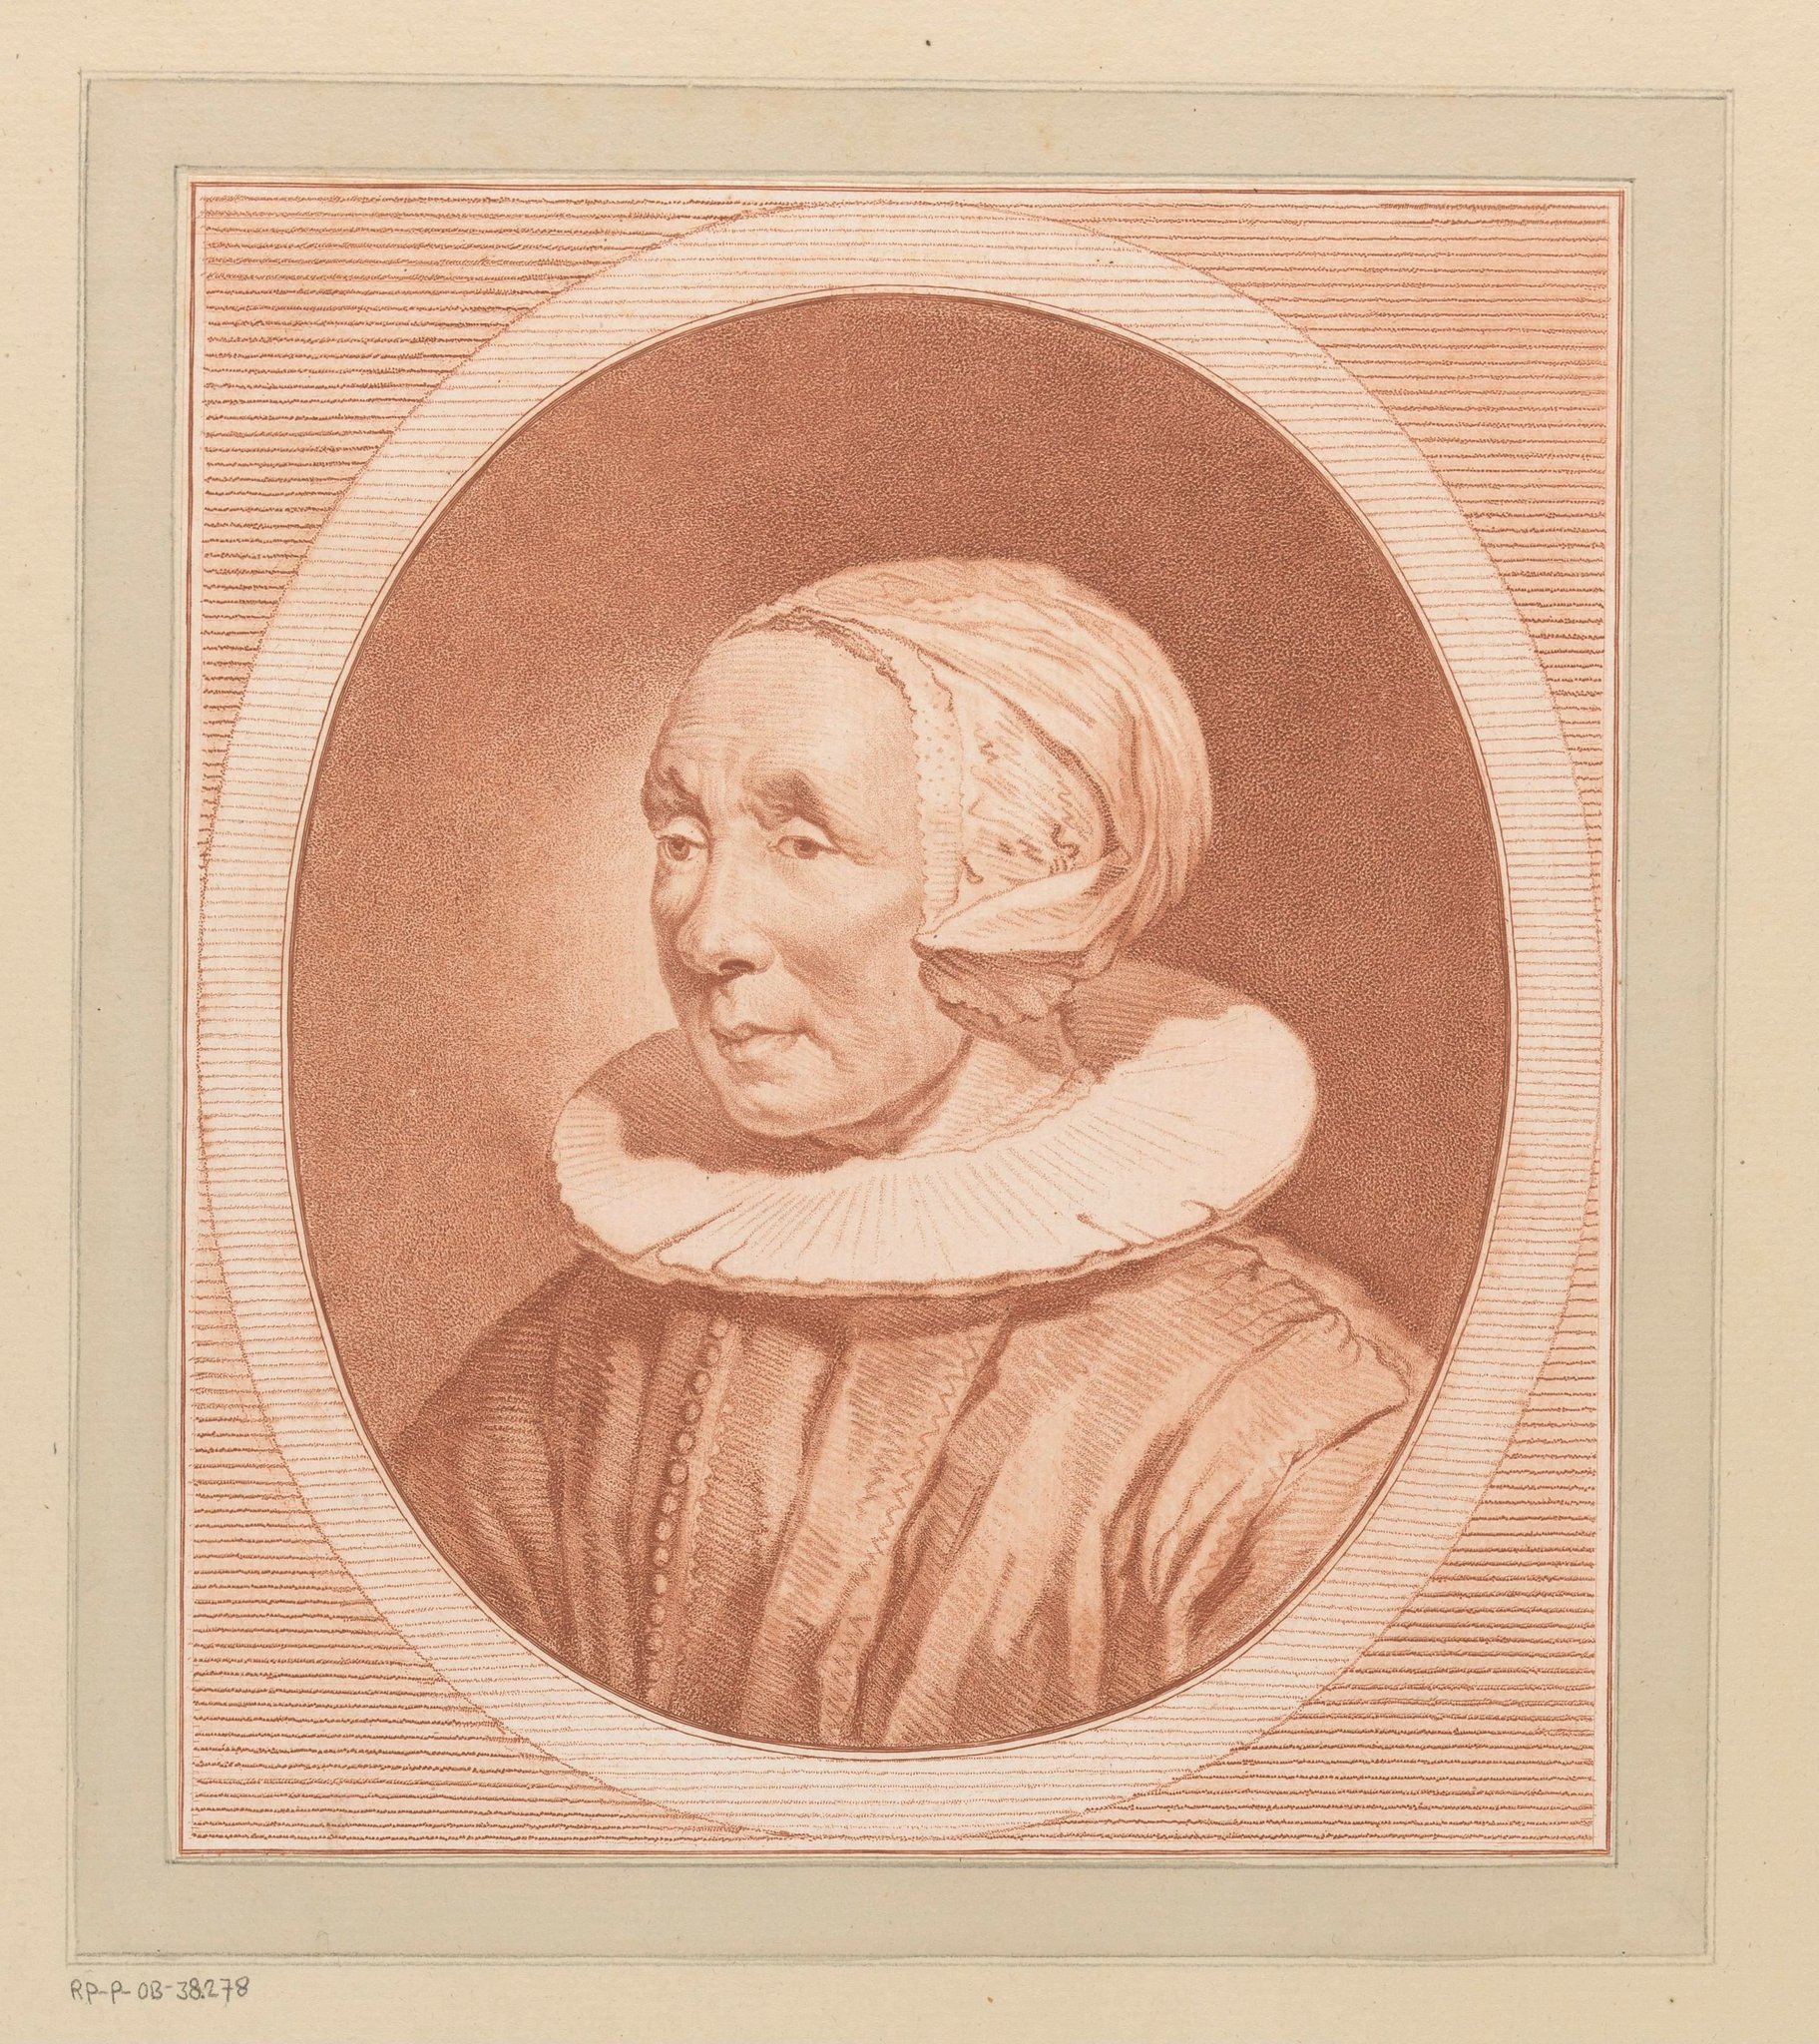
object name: print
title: Portret van een onbekende vrouw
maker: vincenzo vangelisti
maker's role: print maker, publisher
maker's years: 1728-1798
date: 1774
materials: paper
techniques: printing, printmaking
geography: paris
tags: anonymous historical person portrayed alone - bb - woman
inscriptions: collector's mark: Lugt 2228